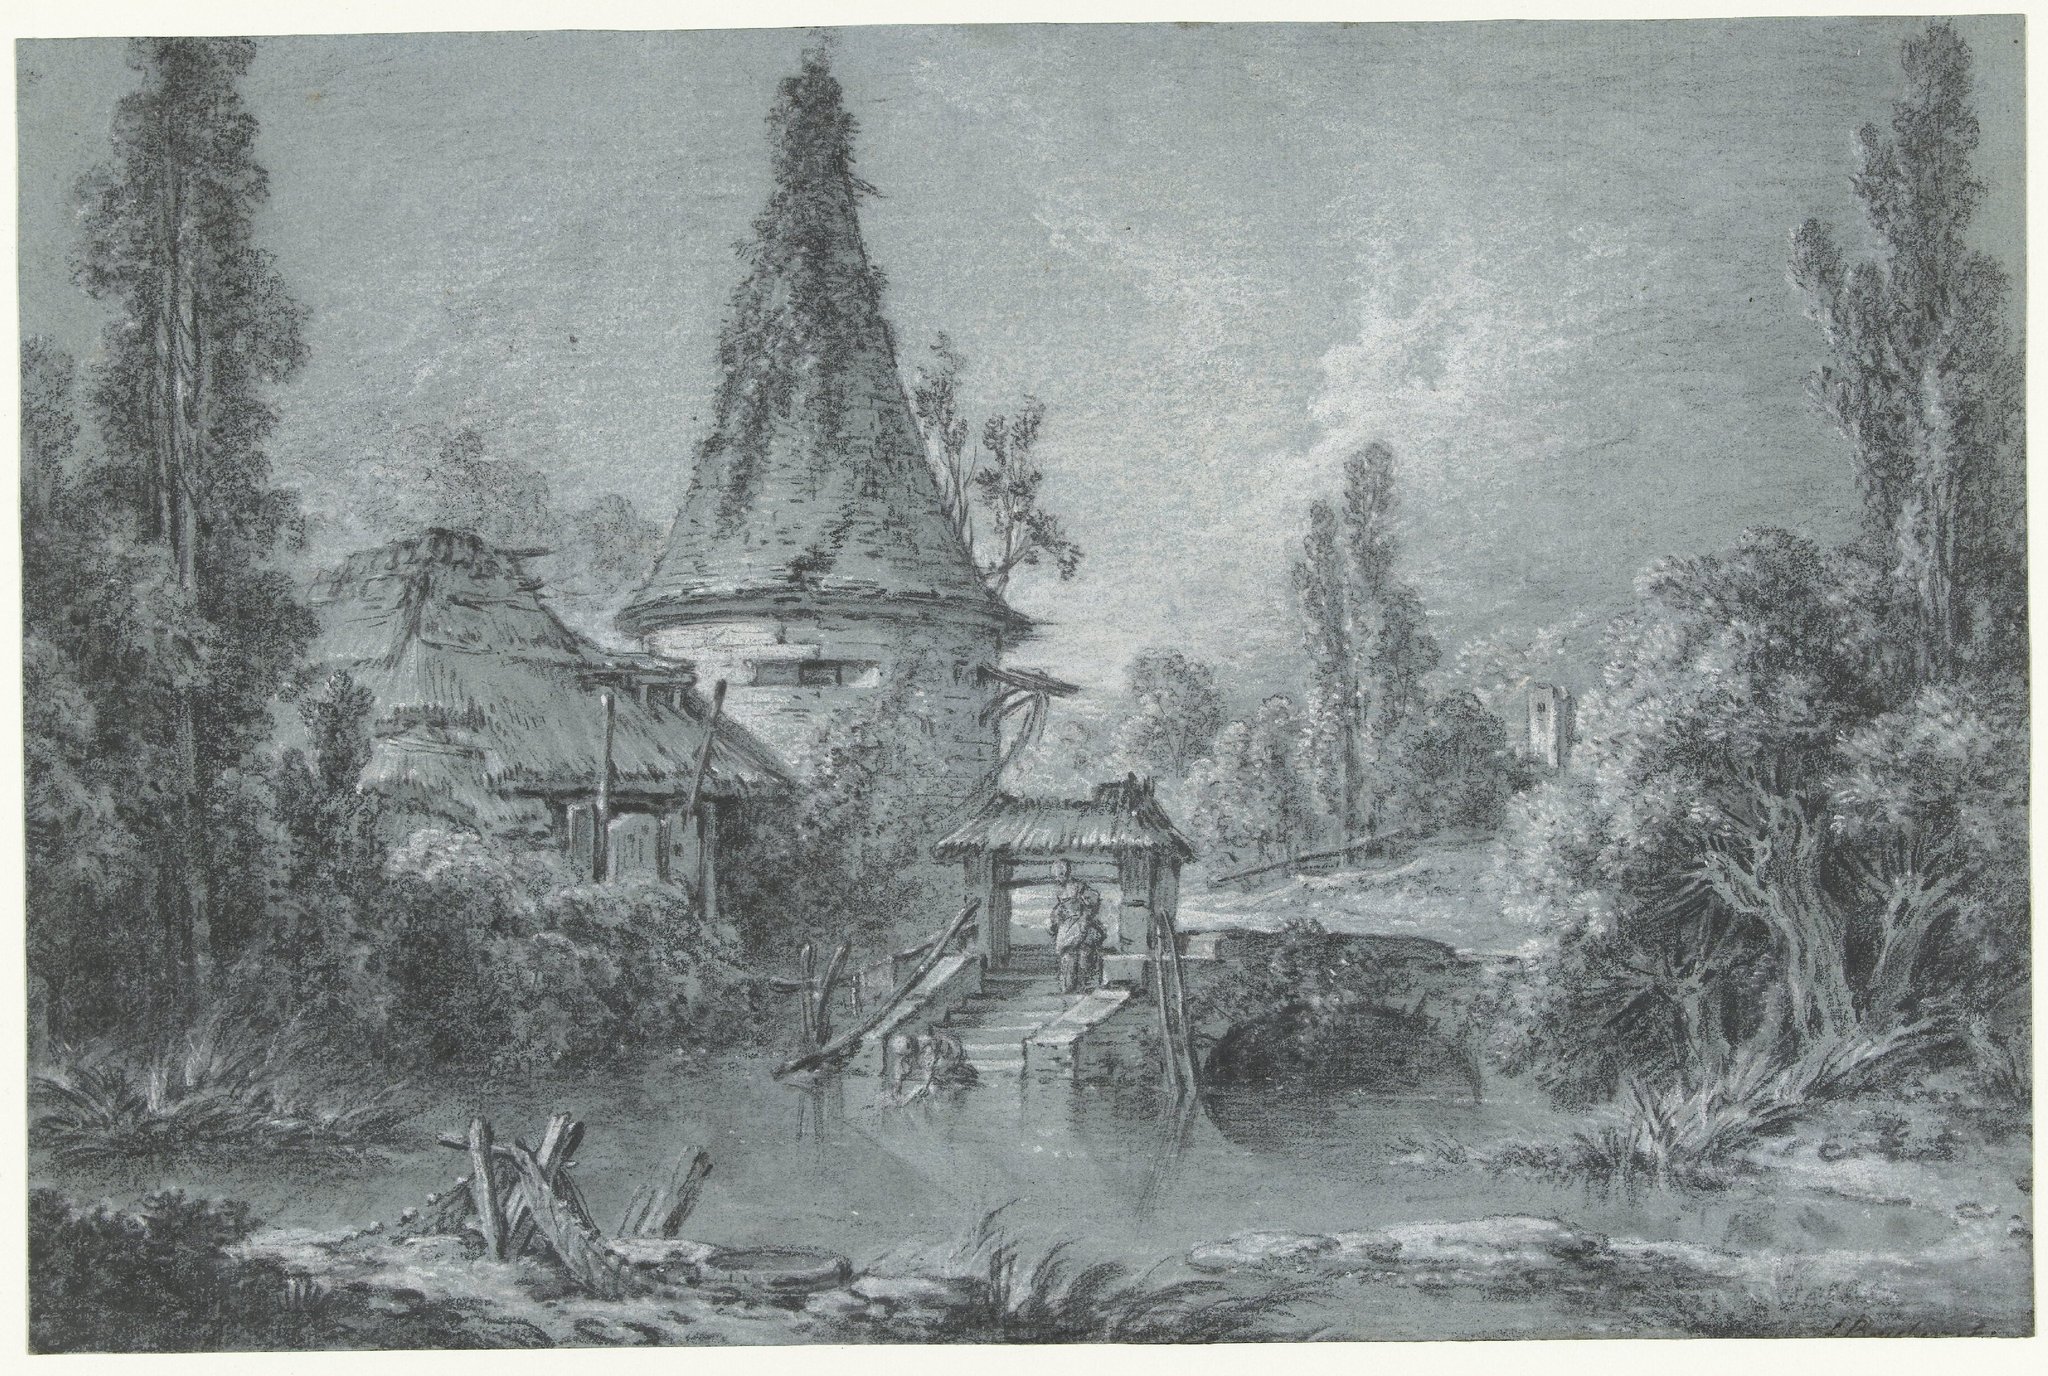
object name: design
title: Landschap met een toren, in de omgeving van Beauvais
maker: françois boucher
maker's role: draughtsman, print maker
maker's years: 1703-1770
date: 1737-1747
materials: chalk, paper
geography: beauvais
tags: landscapes in the temperate zone, tower (of house or building), beauvais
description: In prent gebracht onder de titel 'Vüe d'une Tour près de Blois, que les bonnes gens des Environs croyent habitée par des Esprits, on la nomme comunément la Tour du Diable'.